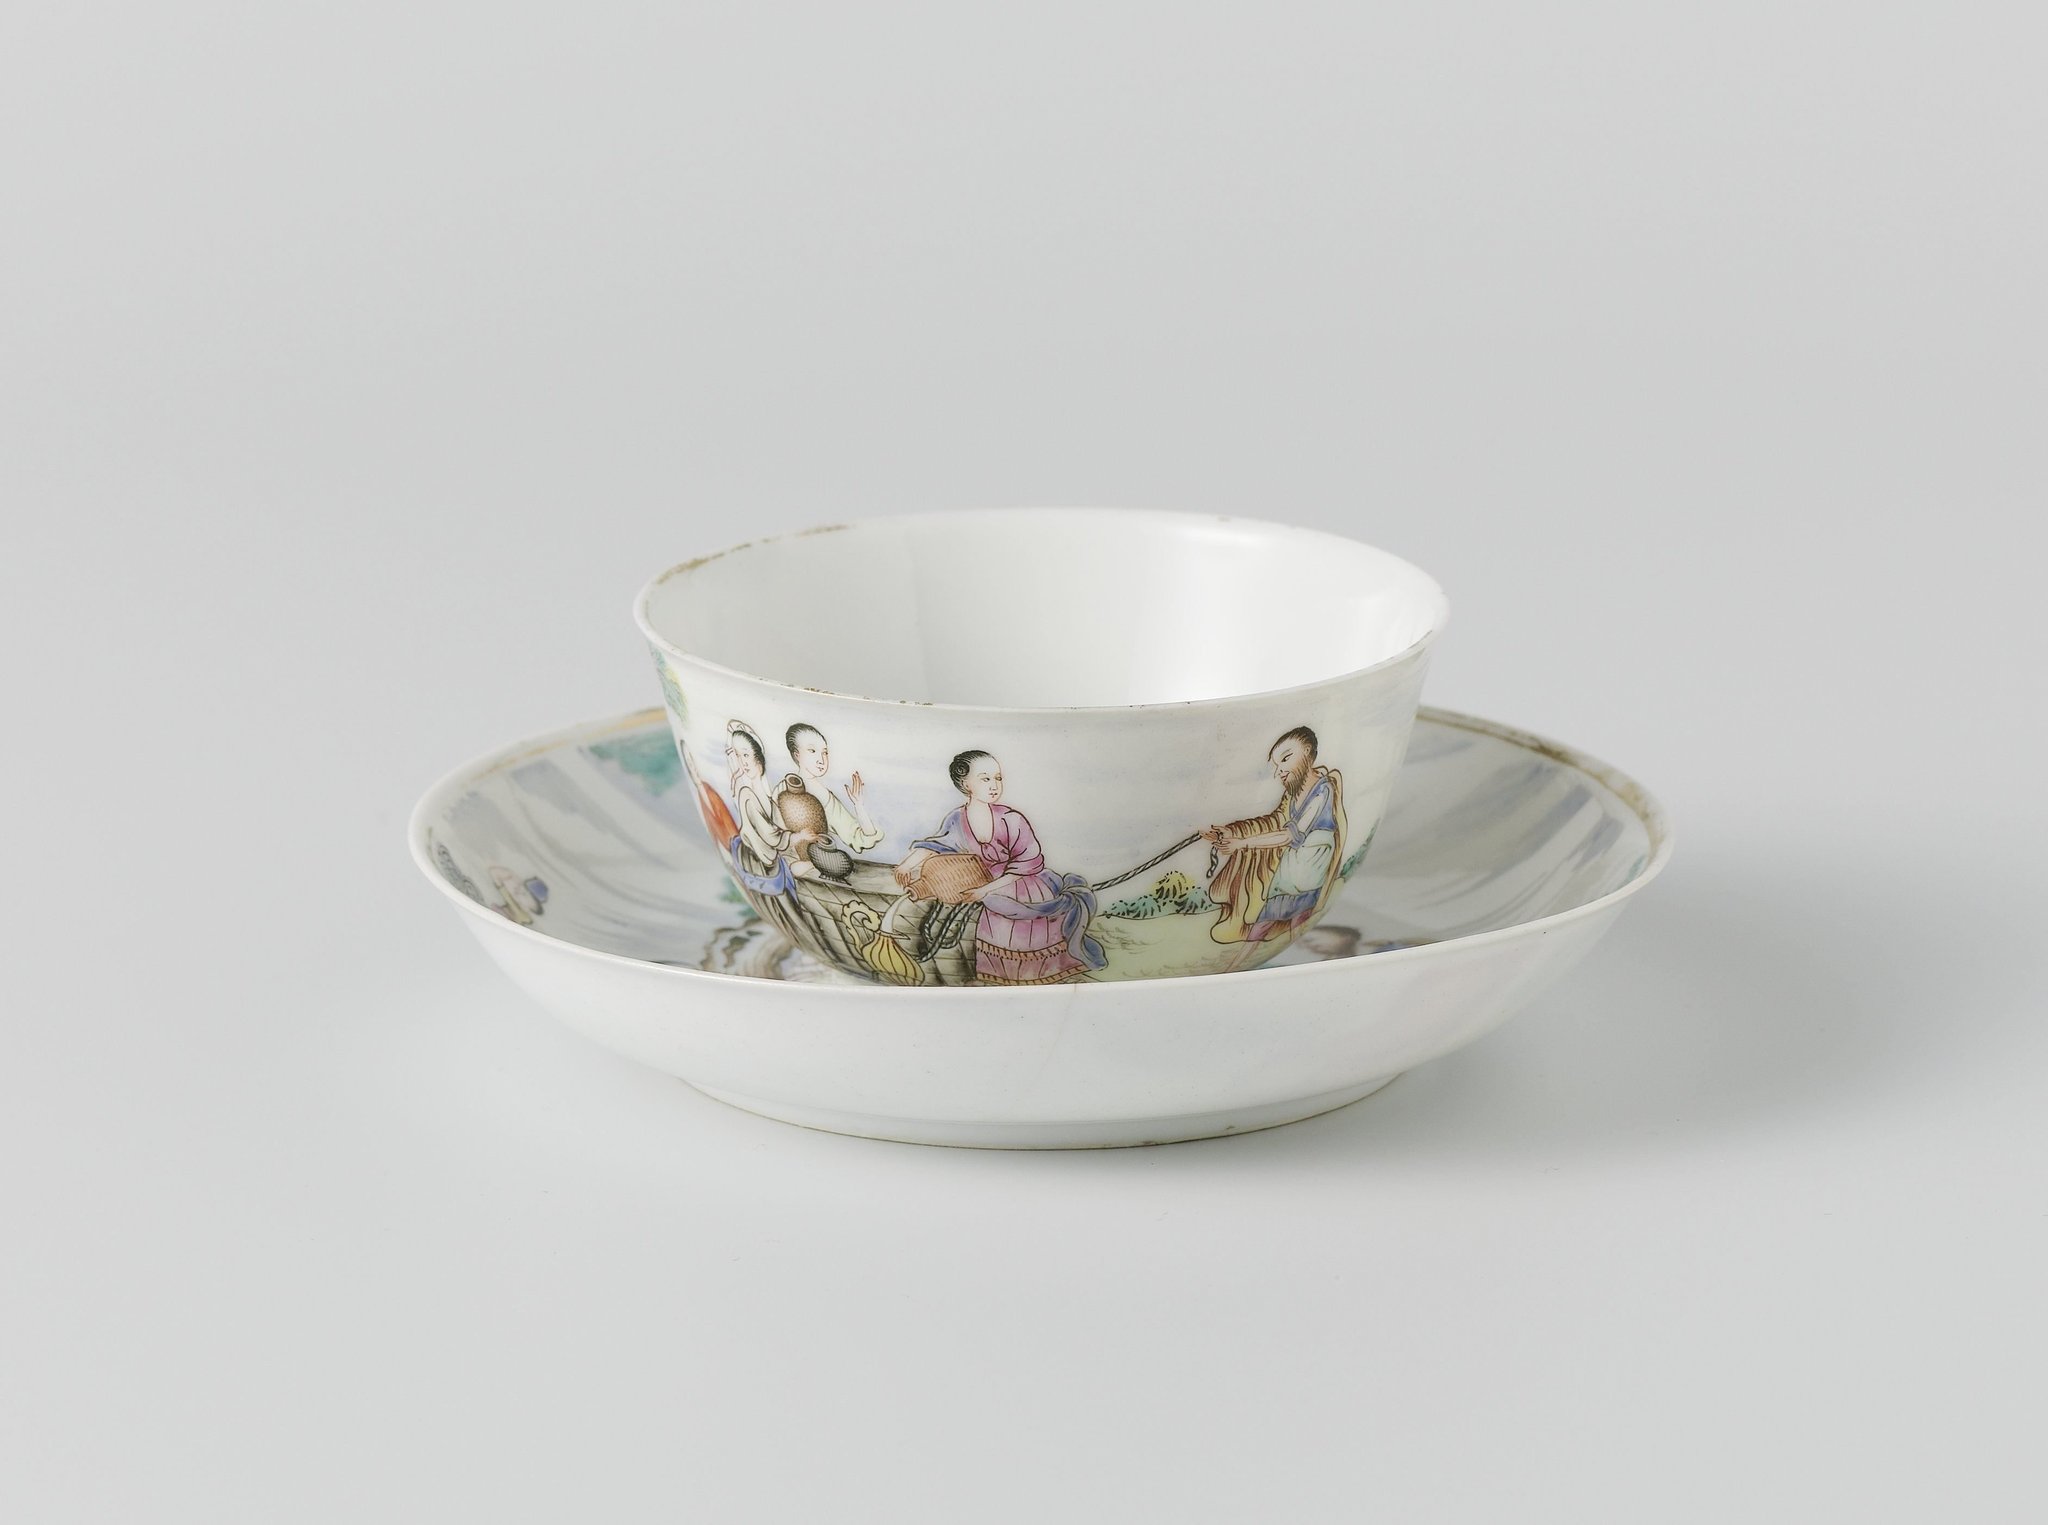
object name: kop en schotel, kop en schotel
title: Bell-shaped cup and saucer with an image of Rebecca at the Well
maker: Anonymous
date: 1750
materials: glaze, gold, paint, porcelain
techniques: firing, gilding, turning, vitrification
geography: china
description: Theekop en platte schotel op een voetring. Gedecoreerd in emailkleuren met een voorstelling van Rebecca bij de bron. Het verhaal van Rebecca wordt verteld in Genesis 24, 15-20. Op de voorstelling is Rebecca te zien, vergezeld door jonge vrouwen die kruiken vasthouden. Rebecca geeft Eliëzer water bij de bron. Eliëzer was de trouwe bediende van Abraham, die hem naar Mesopotamië had gezonden om een vrouw te zoeken voor zijn zoon Isaak.